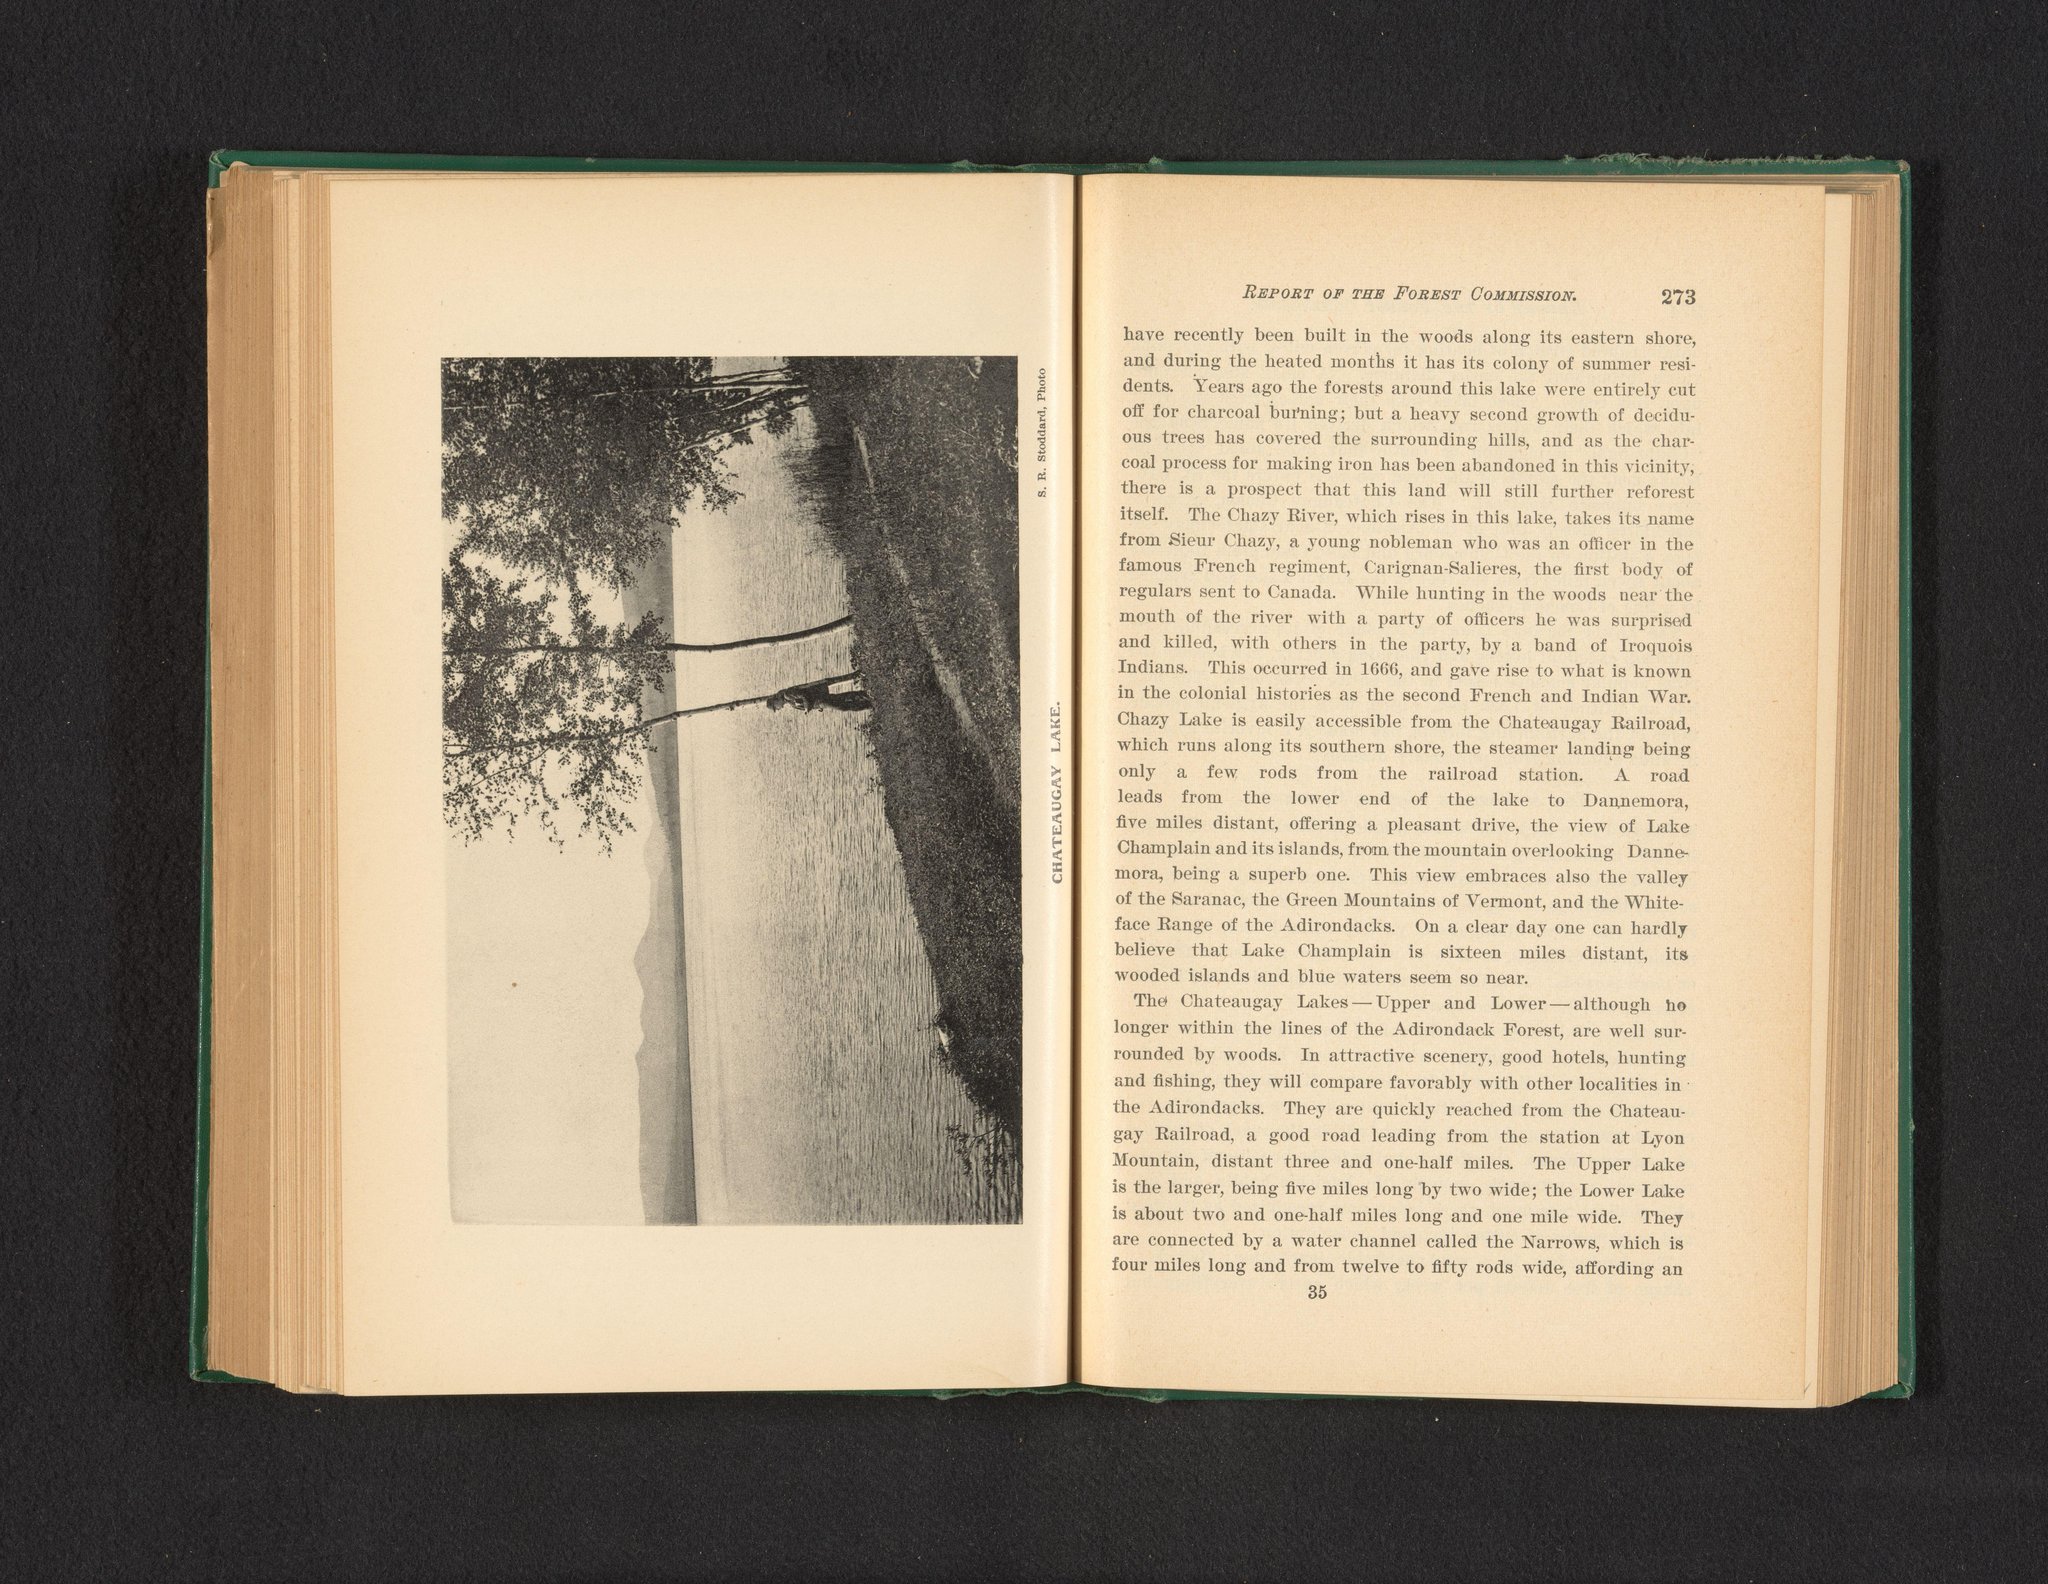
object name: photomechanical print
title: Chateaugay Lake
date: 1893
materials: paper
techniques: photograph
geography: new york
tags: lake